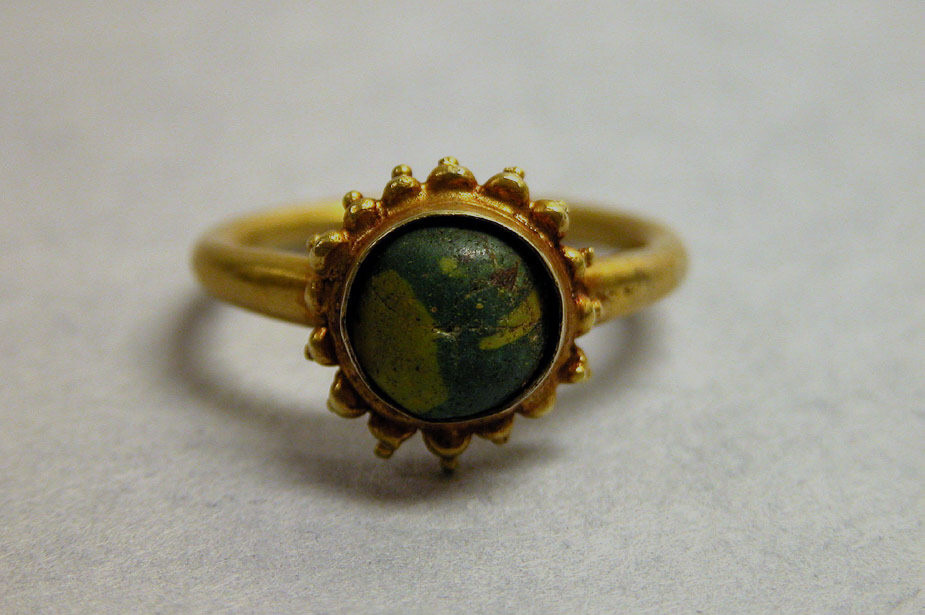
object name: ring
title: Ring with Green Stone in Circular Mount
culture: indonesian, javanese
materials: gold, stone